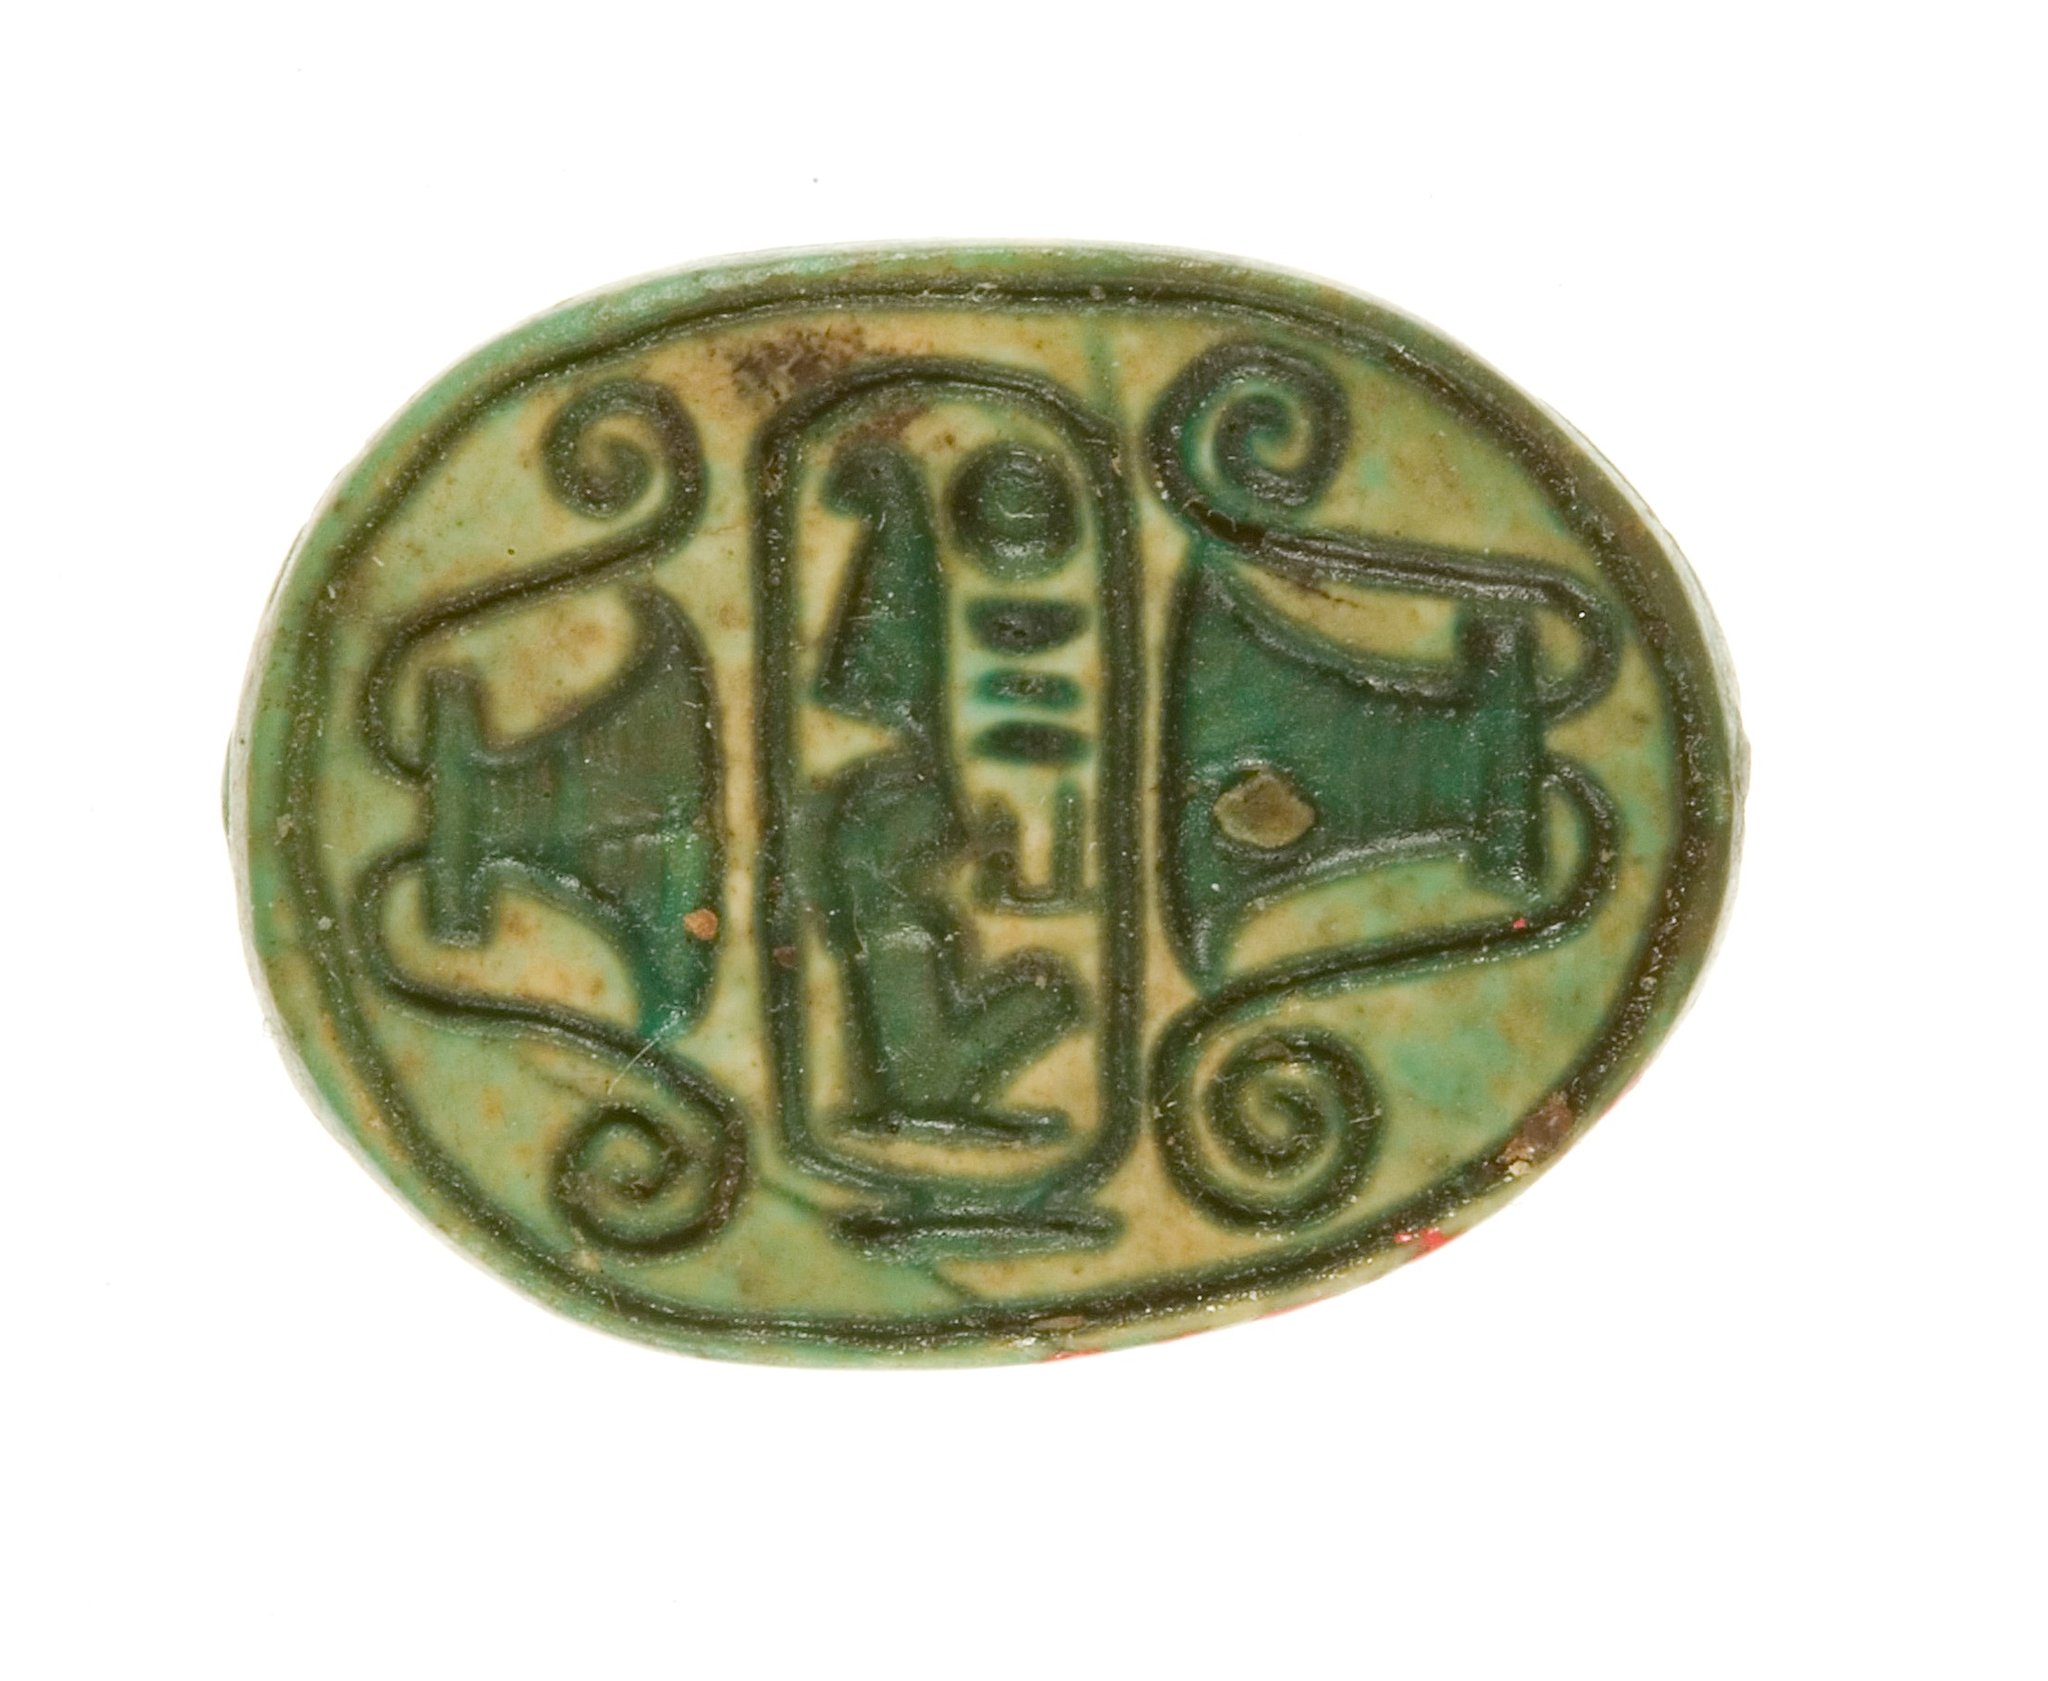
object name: scarab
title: Scarab Inscribed Lord of the Two Lands, Maatkare (Hatshepsut) Flanked by Lotus Flowers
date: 1479-1458 BCE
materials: stone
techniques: glazing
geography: egypt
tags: cartouches,hieroglyphs,scarabs